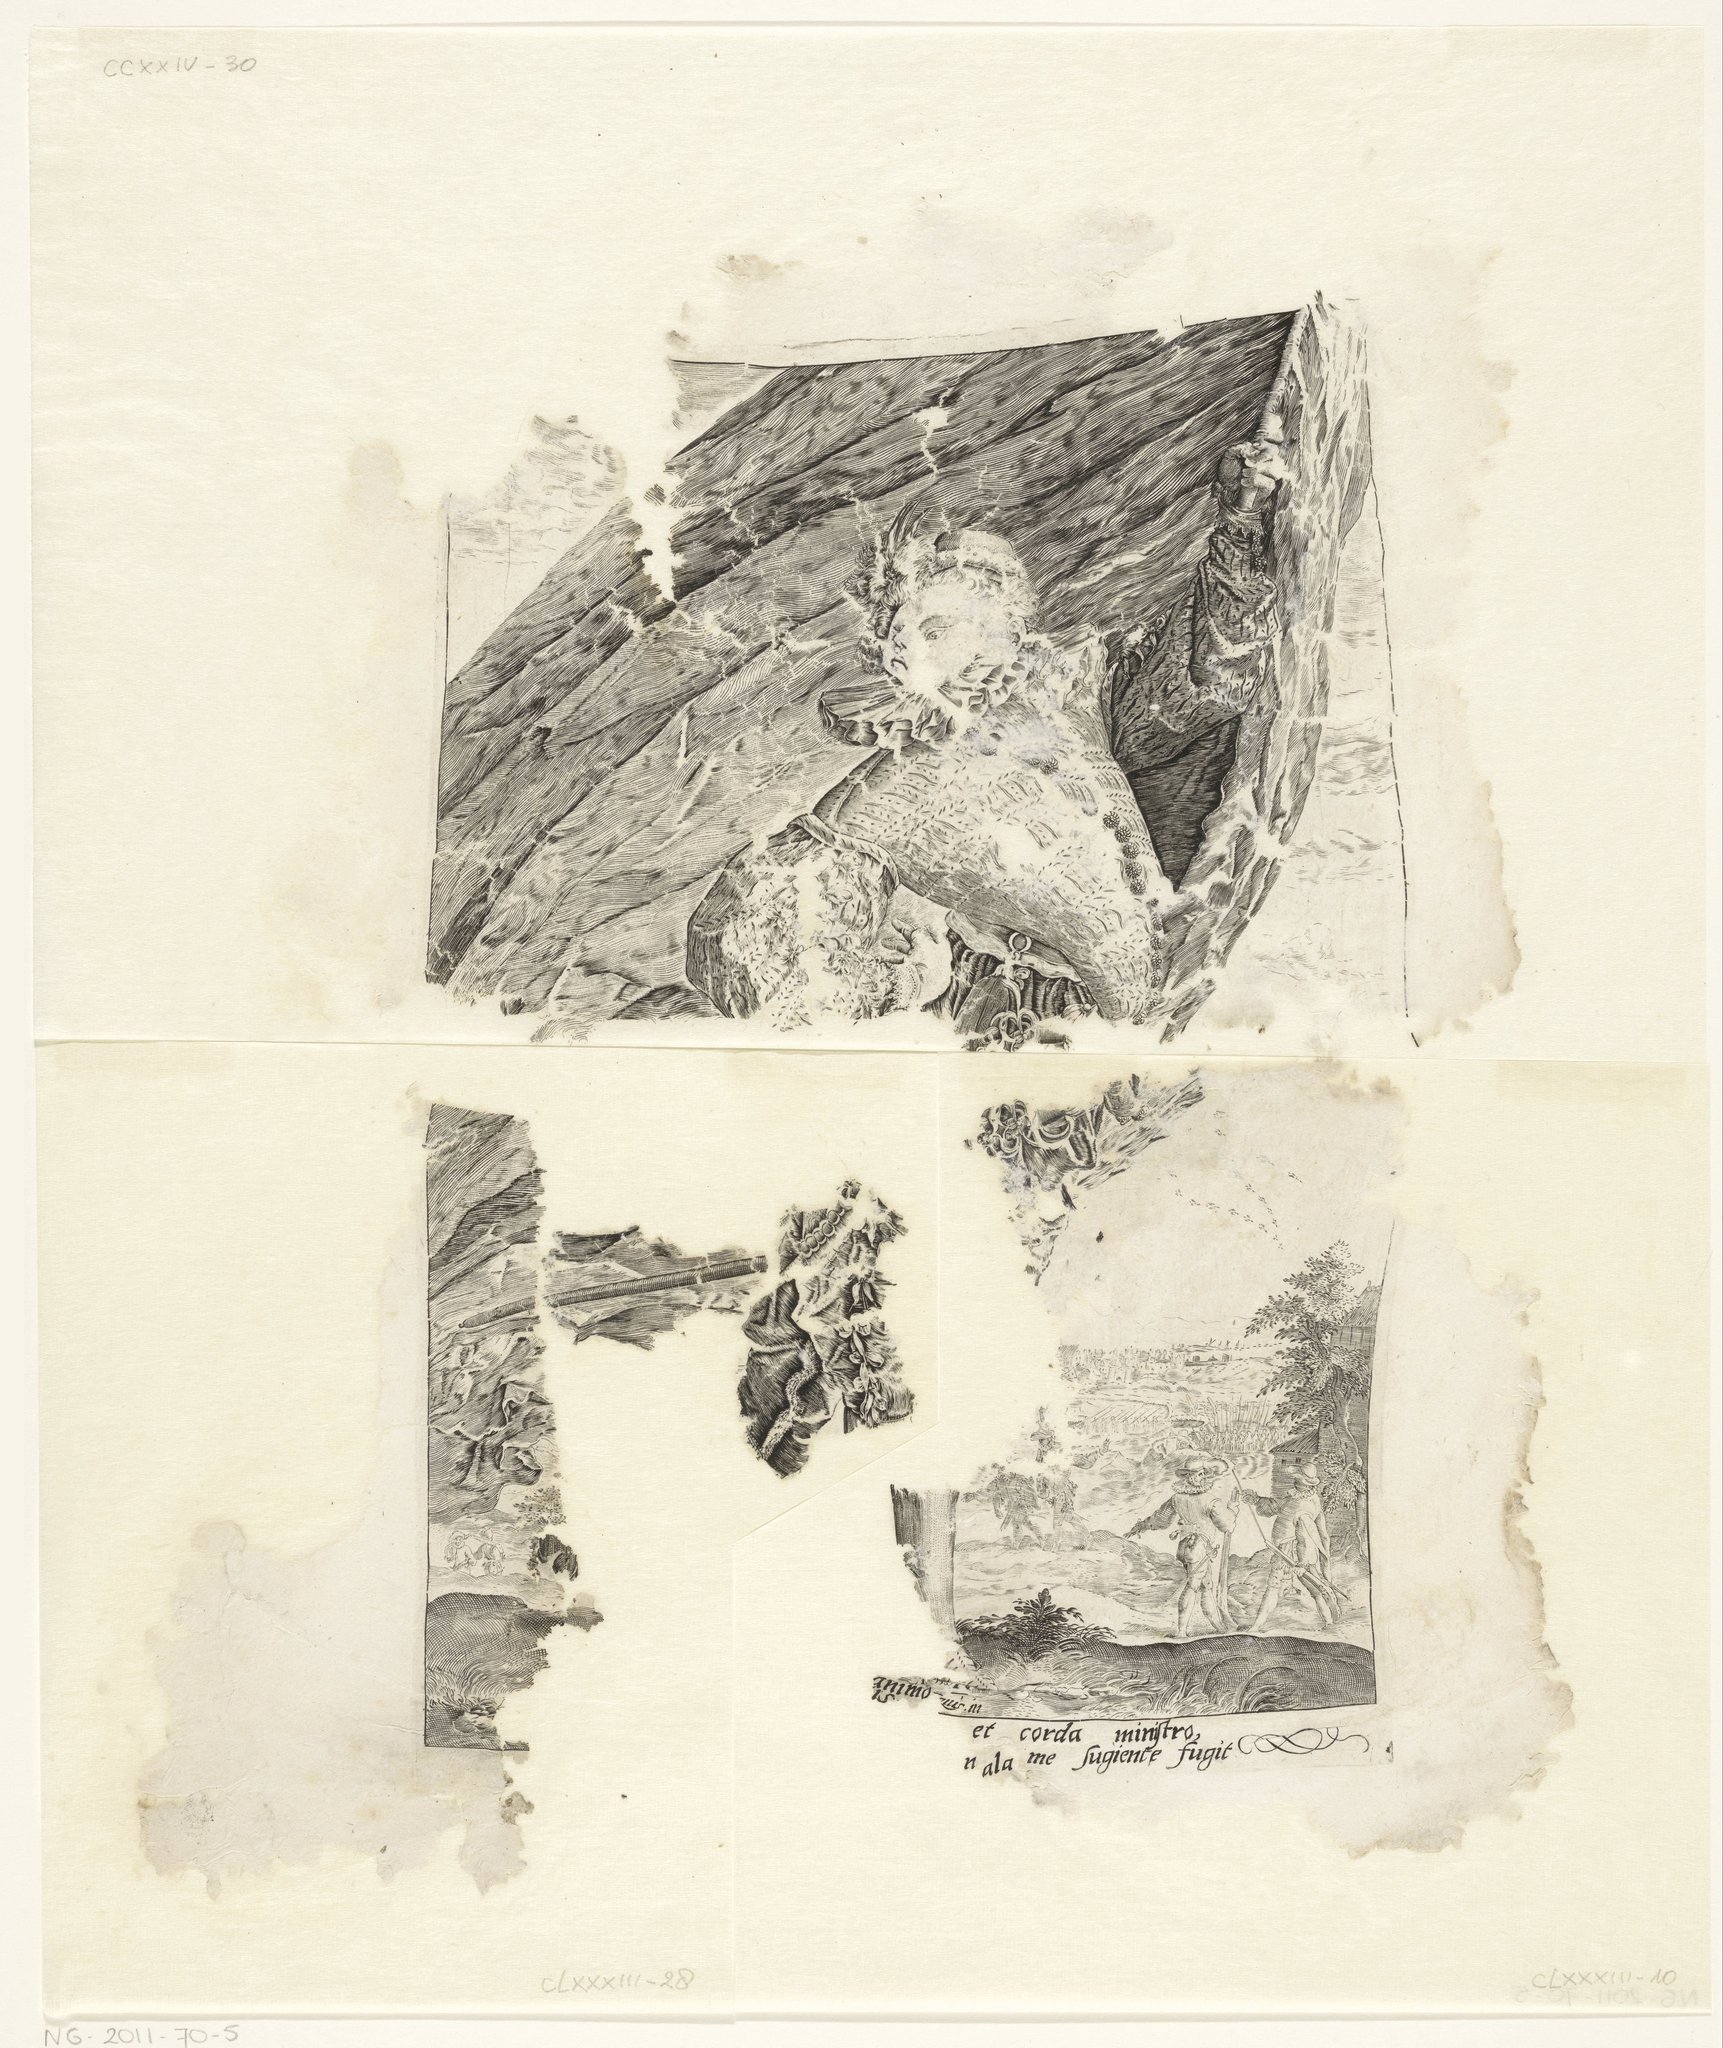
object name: print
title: Vaandeldrager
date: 1587-1596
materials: paper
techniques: engraving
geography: northern netherlands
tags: (military) standard-bearer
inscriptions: watermark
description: De prenten in de Nova Zembla collectie zijn tijdens een expeditie van Willem Barendsz en Jacob van Heemskerk in 1596-1597 noodgedwongen in het winterkamp, het ‘Behouden Huis’, op het eiland achtergelaten. De prenten waren in één of meerdere stapels als handelswaar meegenomen vanuit Amsterdam. Bijna drie eeuwen later, in 1871, keerde de Noor Elling Carlsen terug naar Nova Zembla en vond daar de restanten van het ‘Behouden Huis, inclusief een groot deel van de inventaris. Een deel van de prenten, in de vorm van aaneengekoekte kluiten, werd toen ook teruggevonden. De papierkluiten waren soms op meerdere plekken gebroken. Tussen 1975-1979 zijn de prenten van elkaar gescheiden. Dit leverde in totaal ca. 1000 fragmenten van ca. 400 afdrukken van ca. 150 verschillende prenten op. Voor zover mogelijk zijn de fragmenten samengevoegd en zijn de prenten gereconstrueerd.